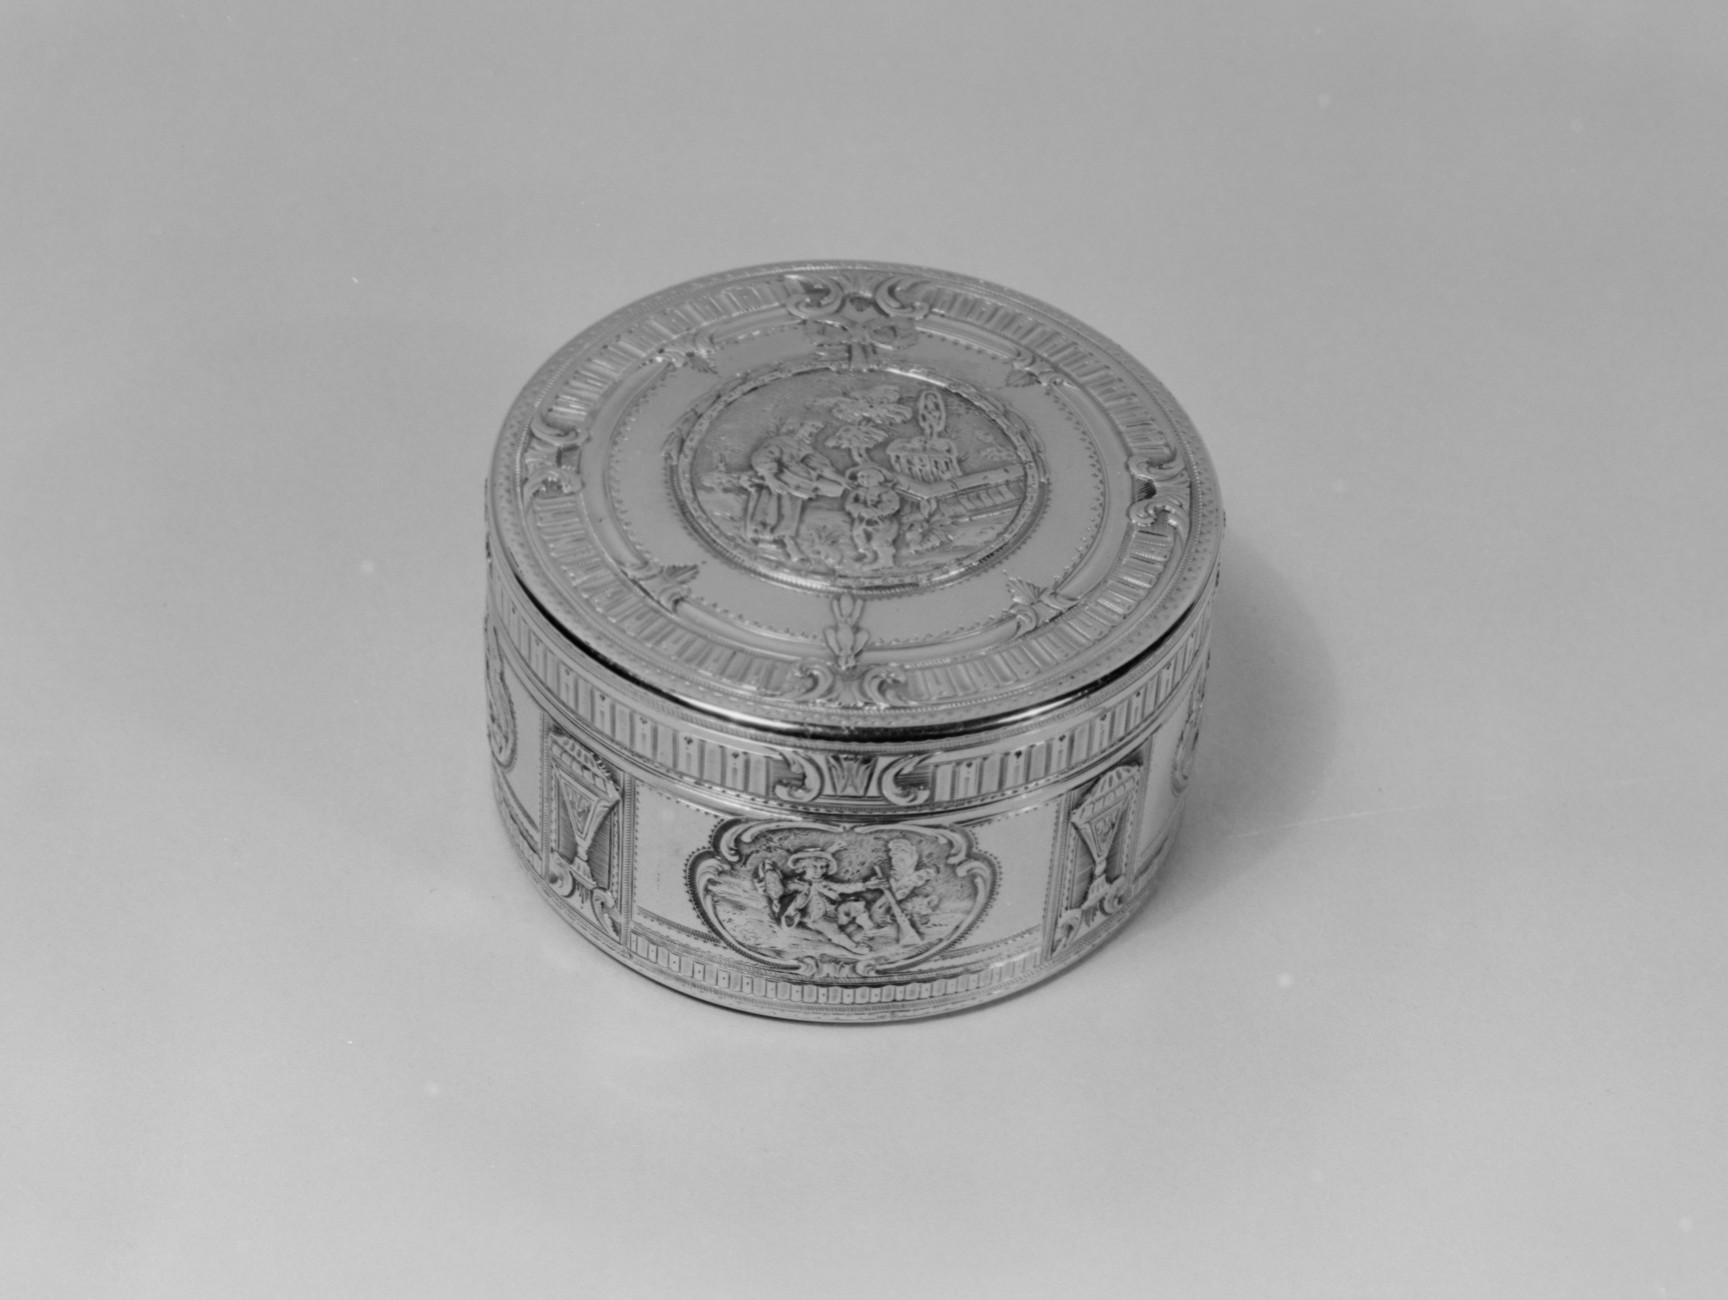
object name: snuffbox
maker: pierre-nicolas pleyard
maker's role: maker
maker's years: 1713-1823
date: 1762-1763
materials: gold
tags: men